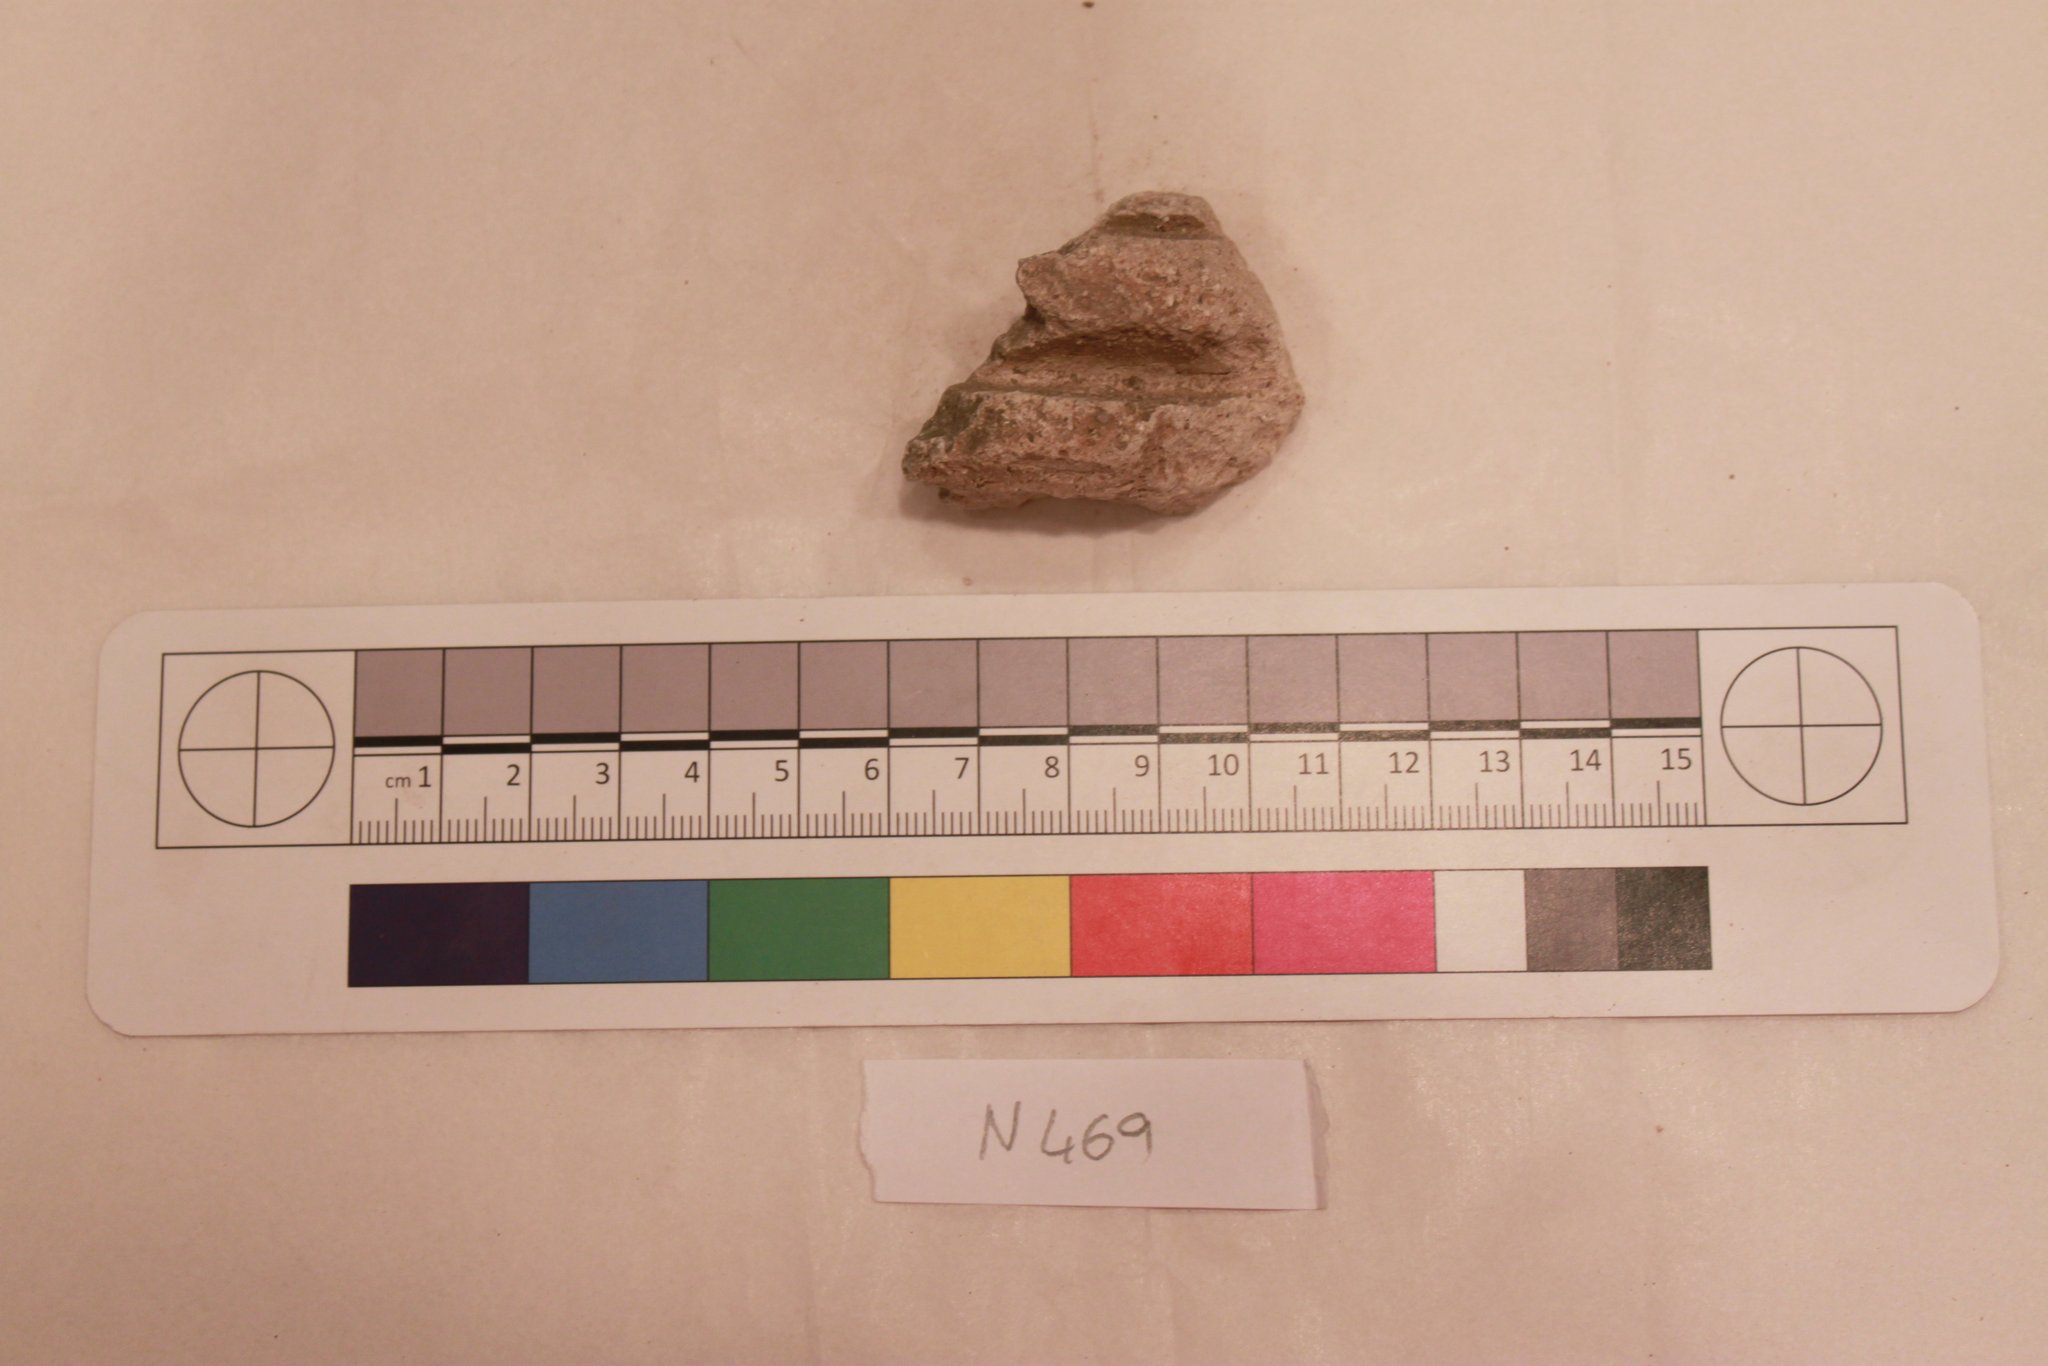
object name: fragment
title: Stucco Fragment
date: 701-1200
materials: plaster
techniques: carving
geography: iran